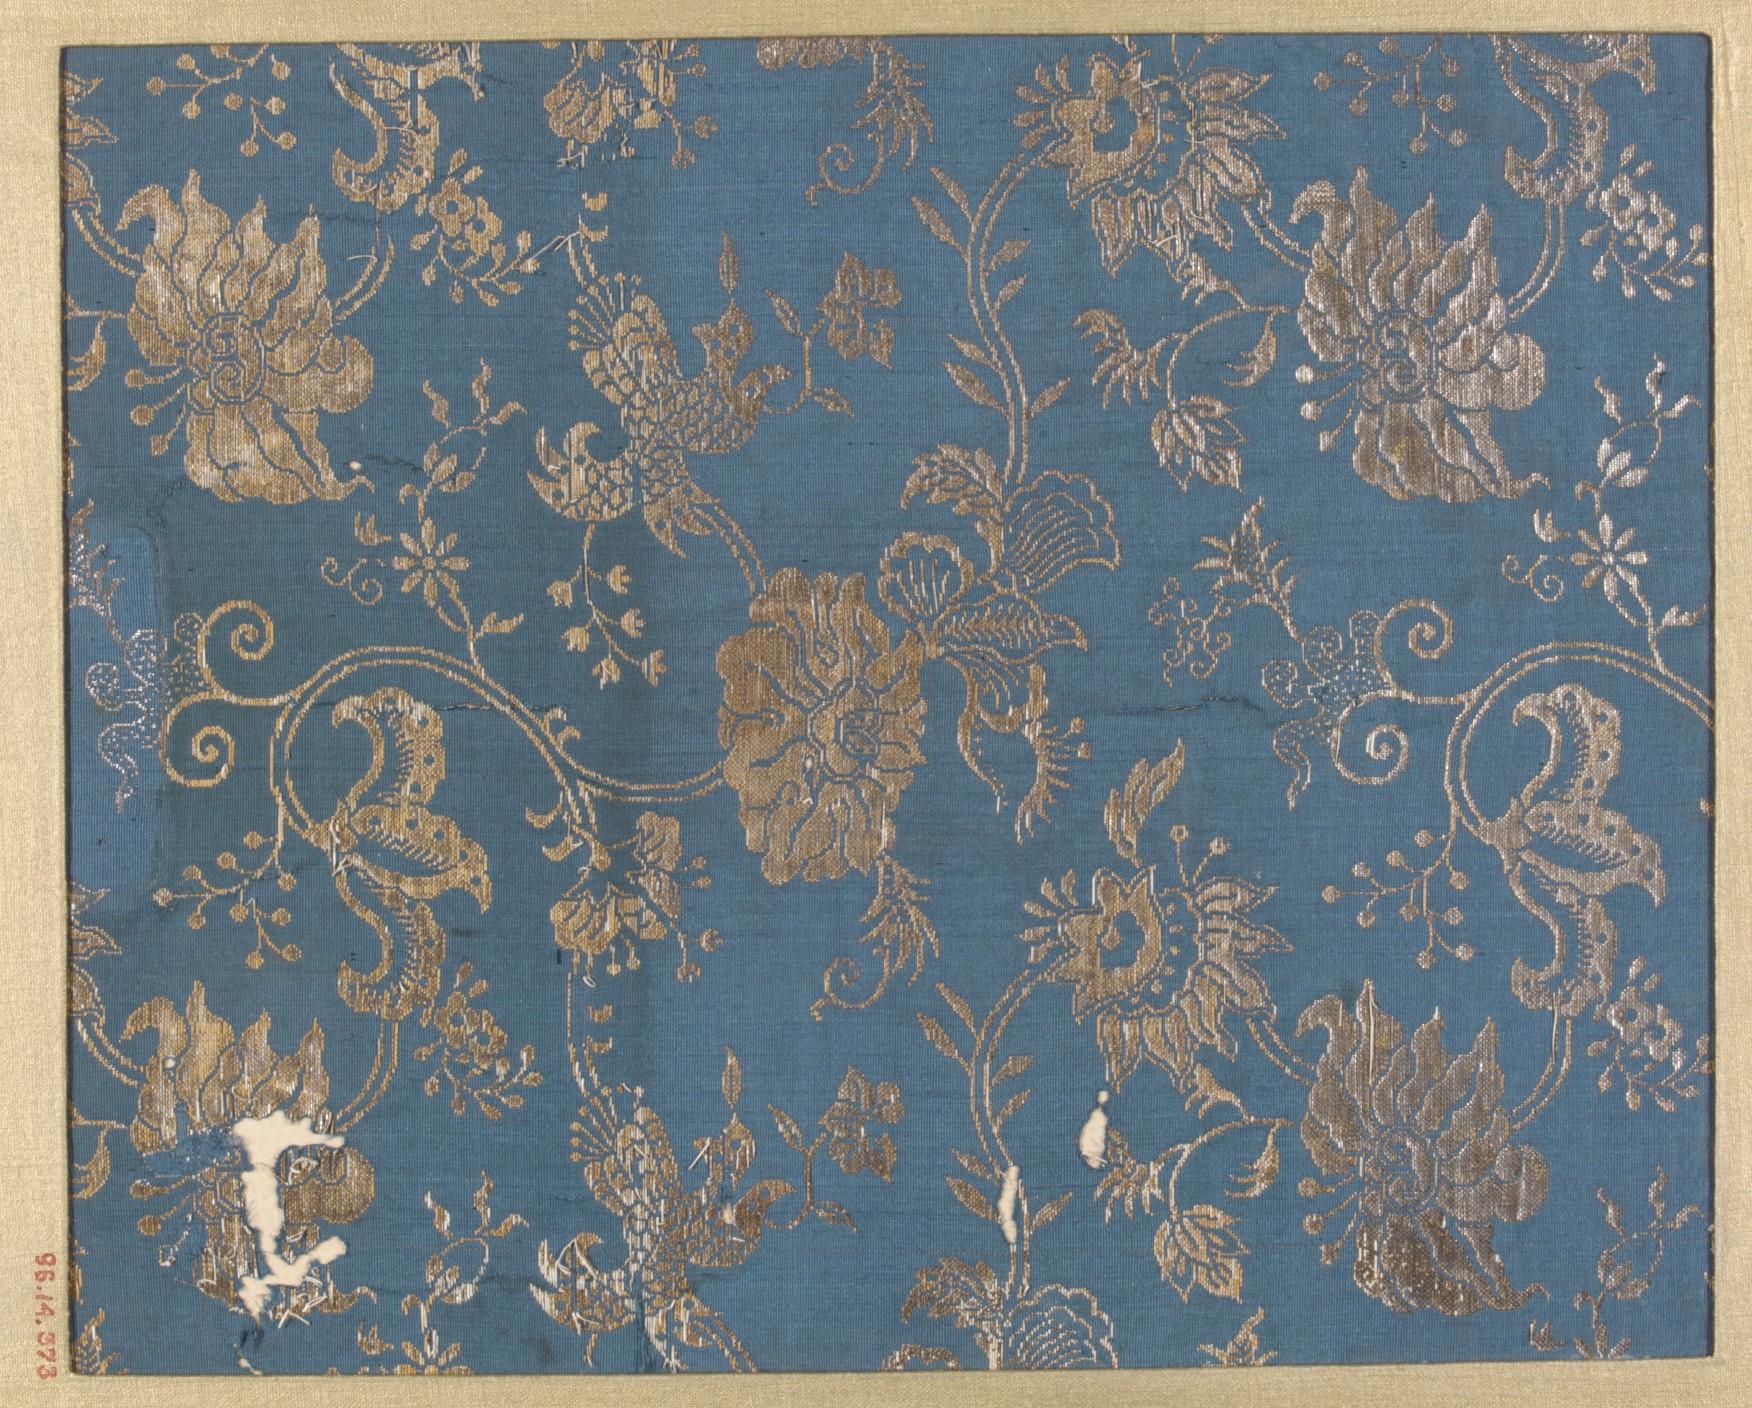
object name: piece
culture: japanese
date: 1701-1900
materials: silk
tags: plants